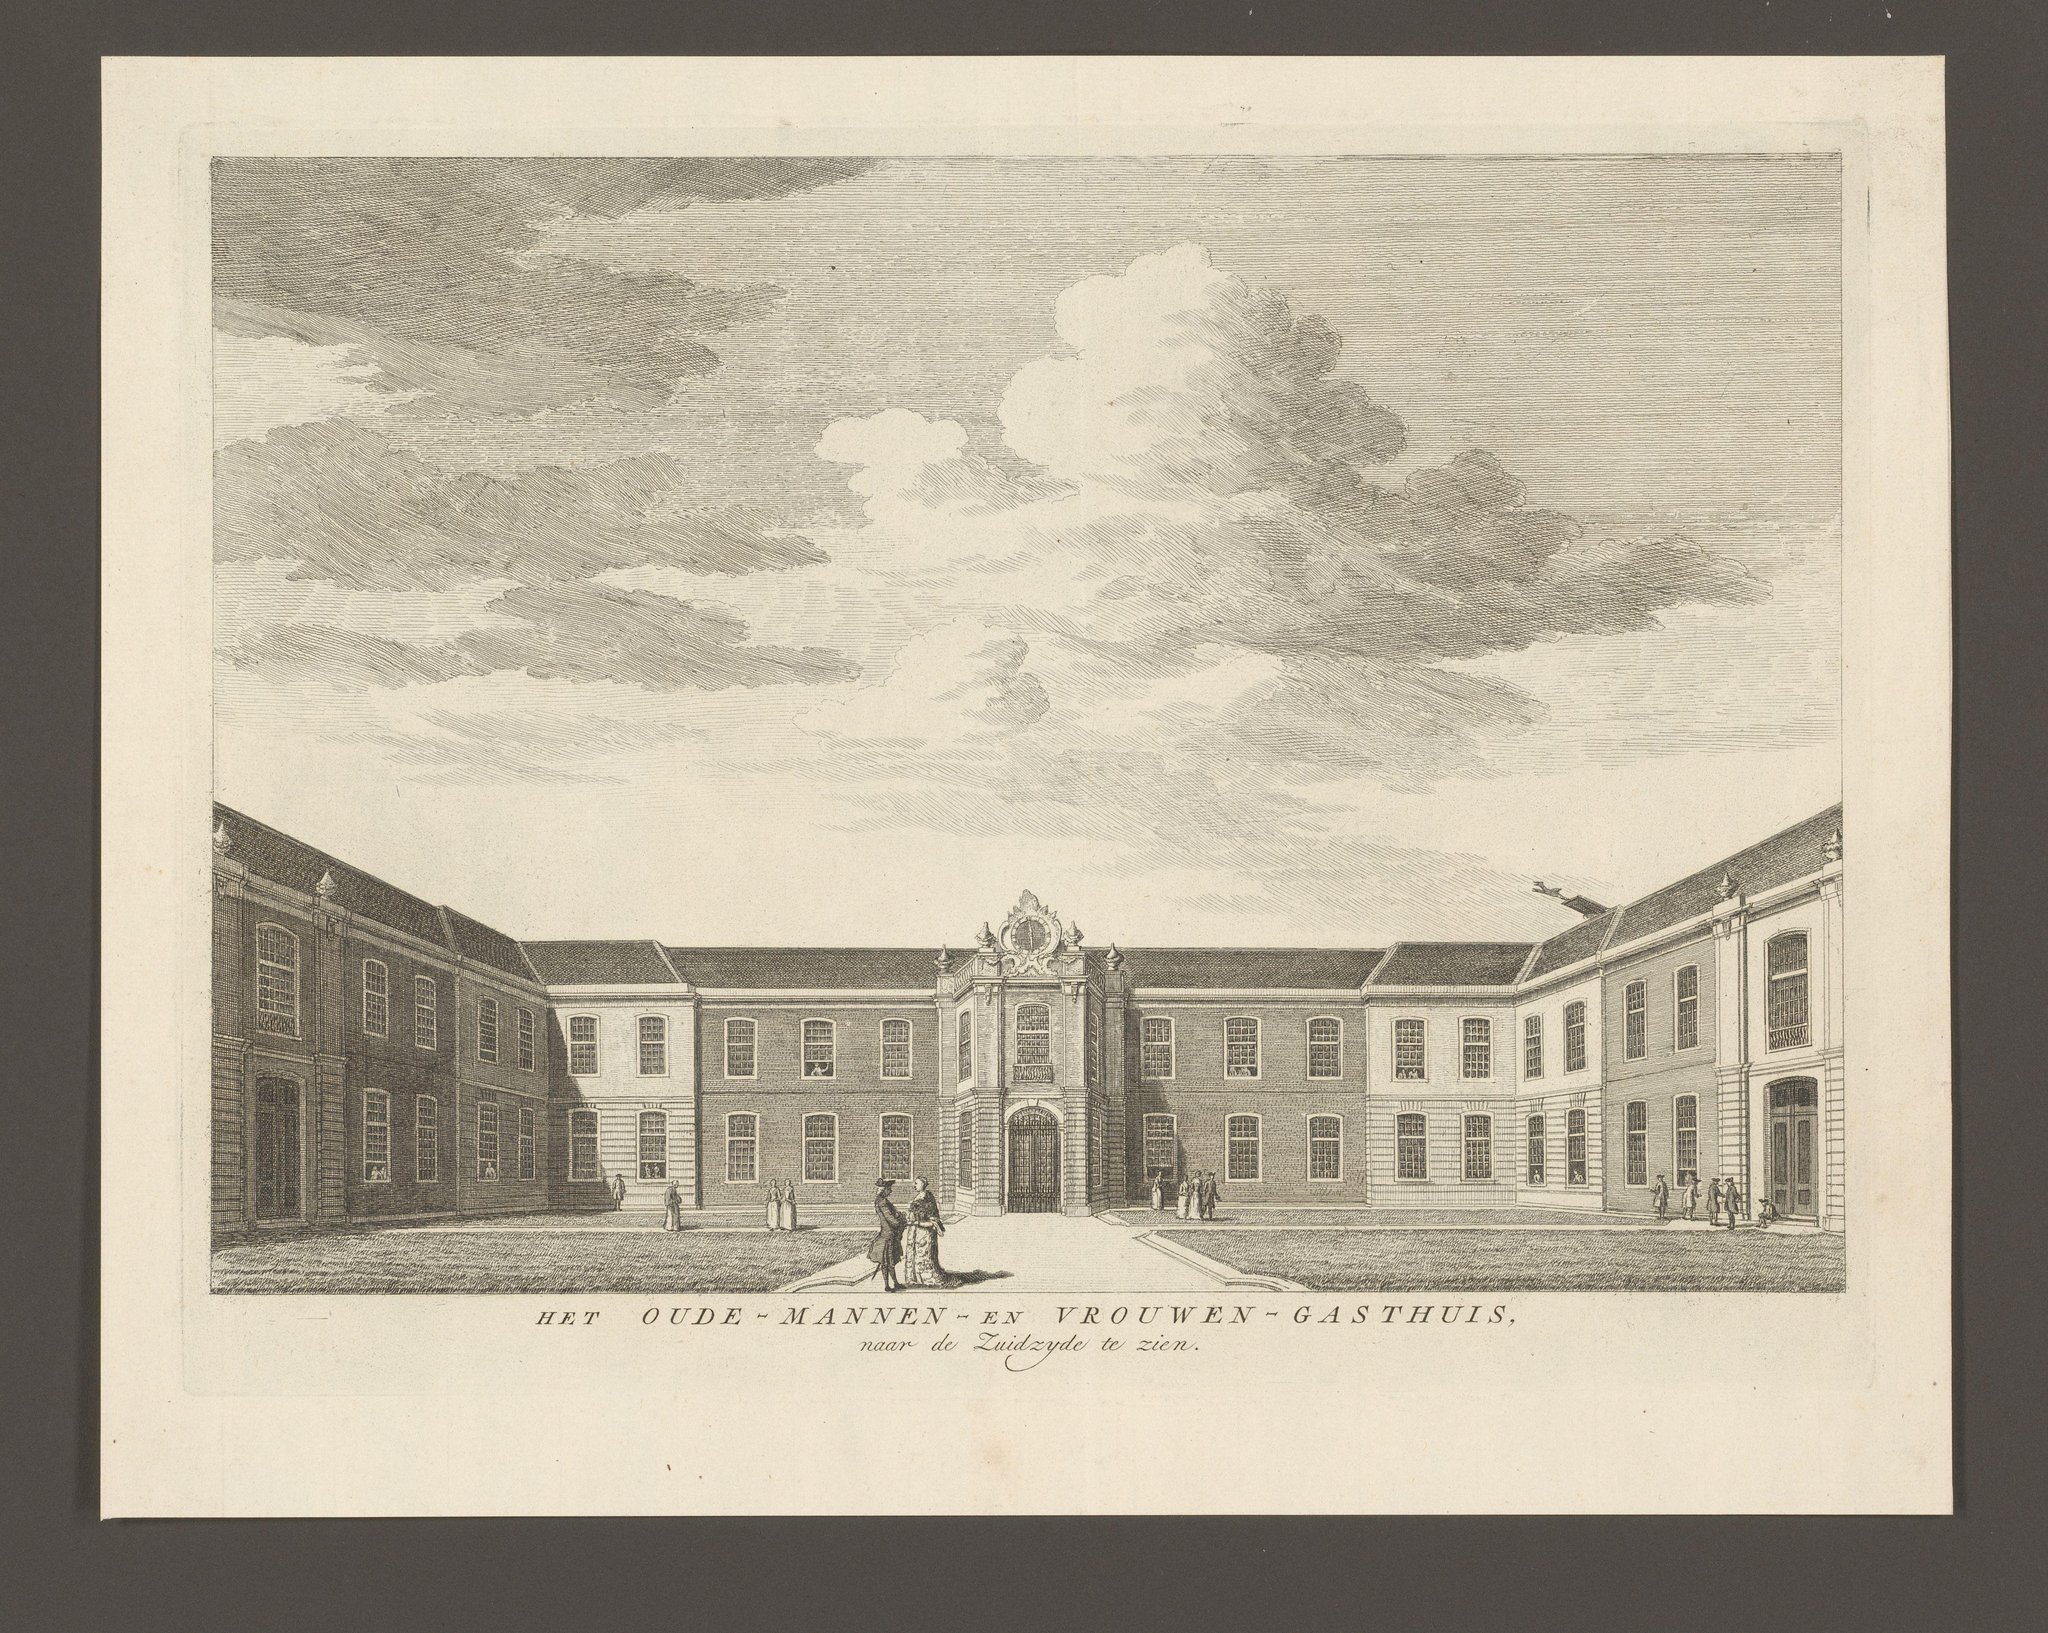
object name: book illustration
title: Gezicht op het Oudemannenhuis te Amsterdam, gezien richting het zuiden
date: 1760-1767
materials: paper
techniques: etching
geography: amsterdam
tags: hospital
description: Prent uit: Wagenaar, Jan. Amsterdam, in zyne opkomst, aanwas, geschiedenissen, enz. 3 dln. Amsterdam: Isaak Tirion, 1760-1767.